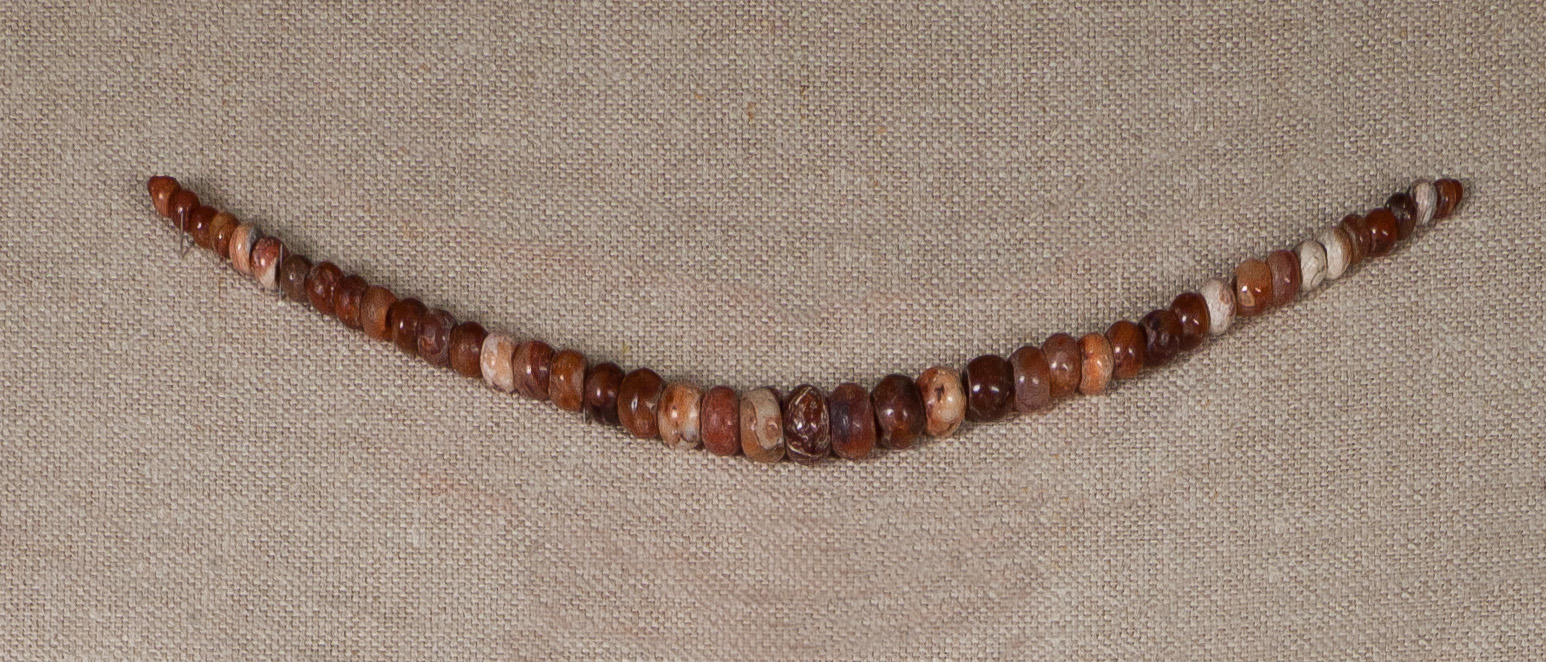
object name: necklace, bead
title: String of Carnelian Ball Beads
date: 1981-1295 BCE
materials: gemstone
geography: egypt